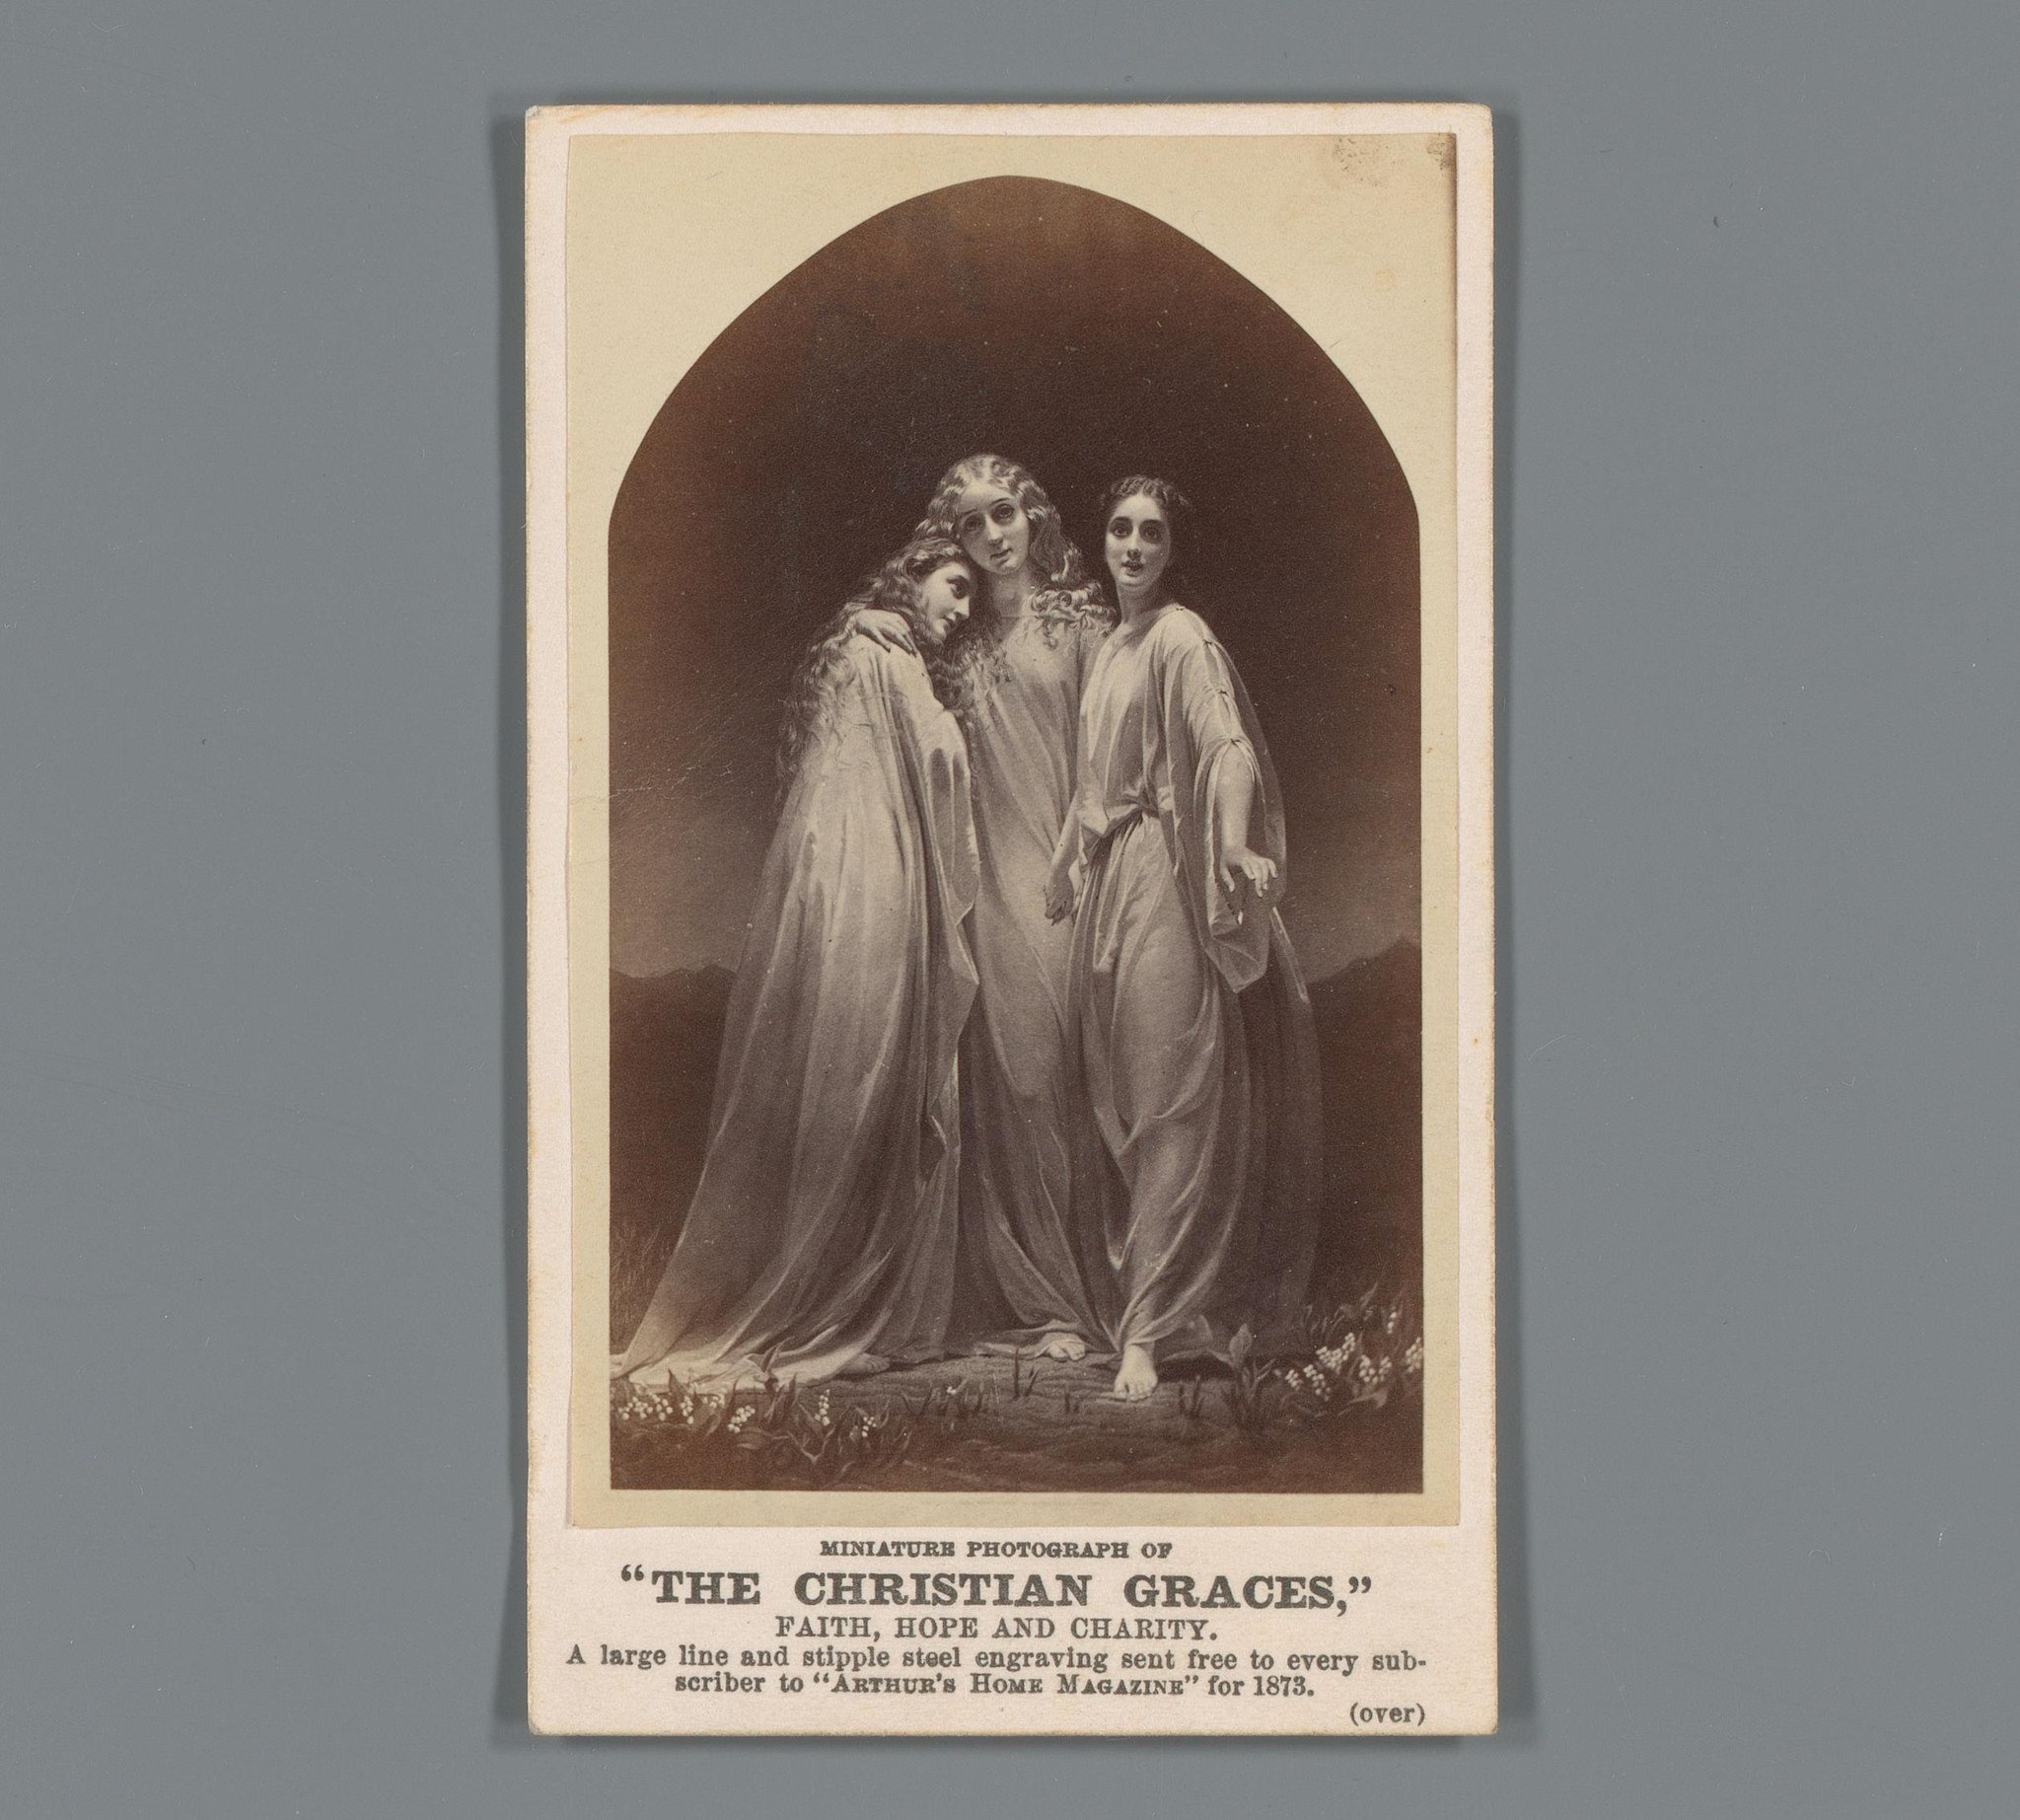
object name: photograph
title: Fotoreproductie van een prent van de drie gratiën uitgegeven door Arthur's Illustrated Home Magazine als bijlage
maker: Anonymous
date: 1873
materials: cardboard, photographic support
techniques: albumen print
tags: weekly, monthly, magazine, etc., advertising, graces (charites), generally three in number; 'gratie' (ripa)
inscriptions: inscription: ‘(...)/ T.S. ARTHUR & SON, Philadelphia, Pa./ (...)’, inscription: ‘A large line and stipple steel engraving sent free to every sub-/ scriber to "ARTHUR HOME MAGAZINE"for 1873.’